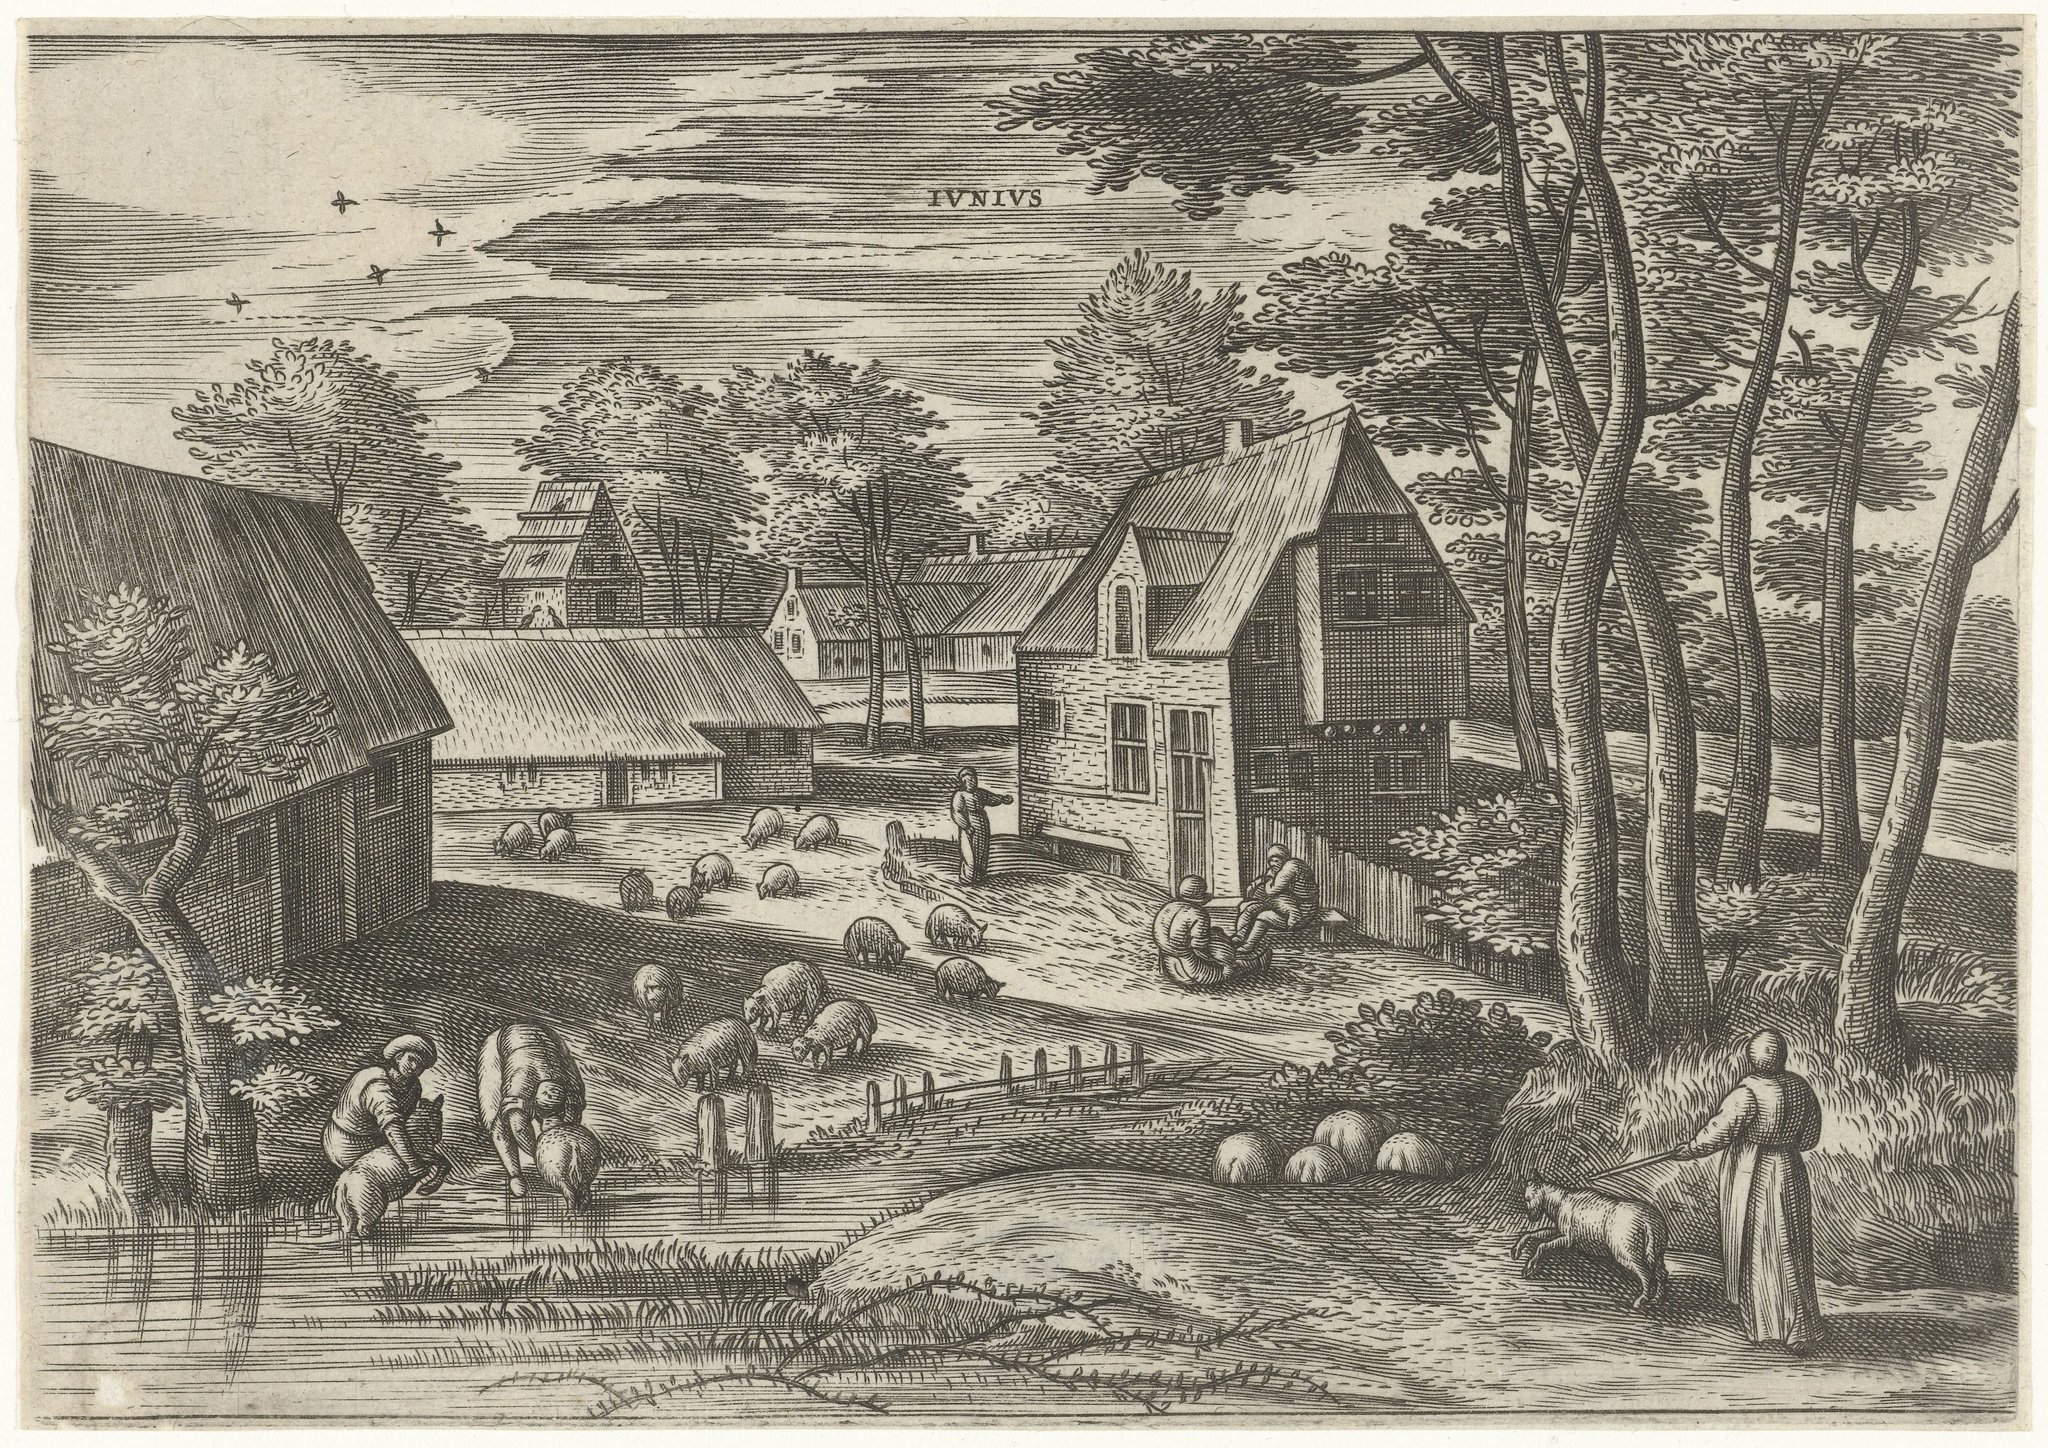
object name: print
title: Juni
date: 1560-1595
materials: paper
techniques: engraving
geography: antwerp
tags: june and its 'labours', dipping, washing (sheep or other animals), shearing (sheep)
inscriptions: collector's mark: Lugt 2228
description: Zomerlandschap met zomertaferelen.Juni is de scheermaand. In het midden een boerderij. Boeren wassen en scheren de schapen. Deel van een serie van de twaalf maanden, waarbij elke maand wordt afgebeeld met de voor haar typerende menselijke activiteiten en haar klimatologische kenmerken.